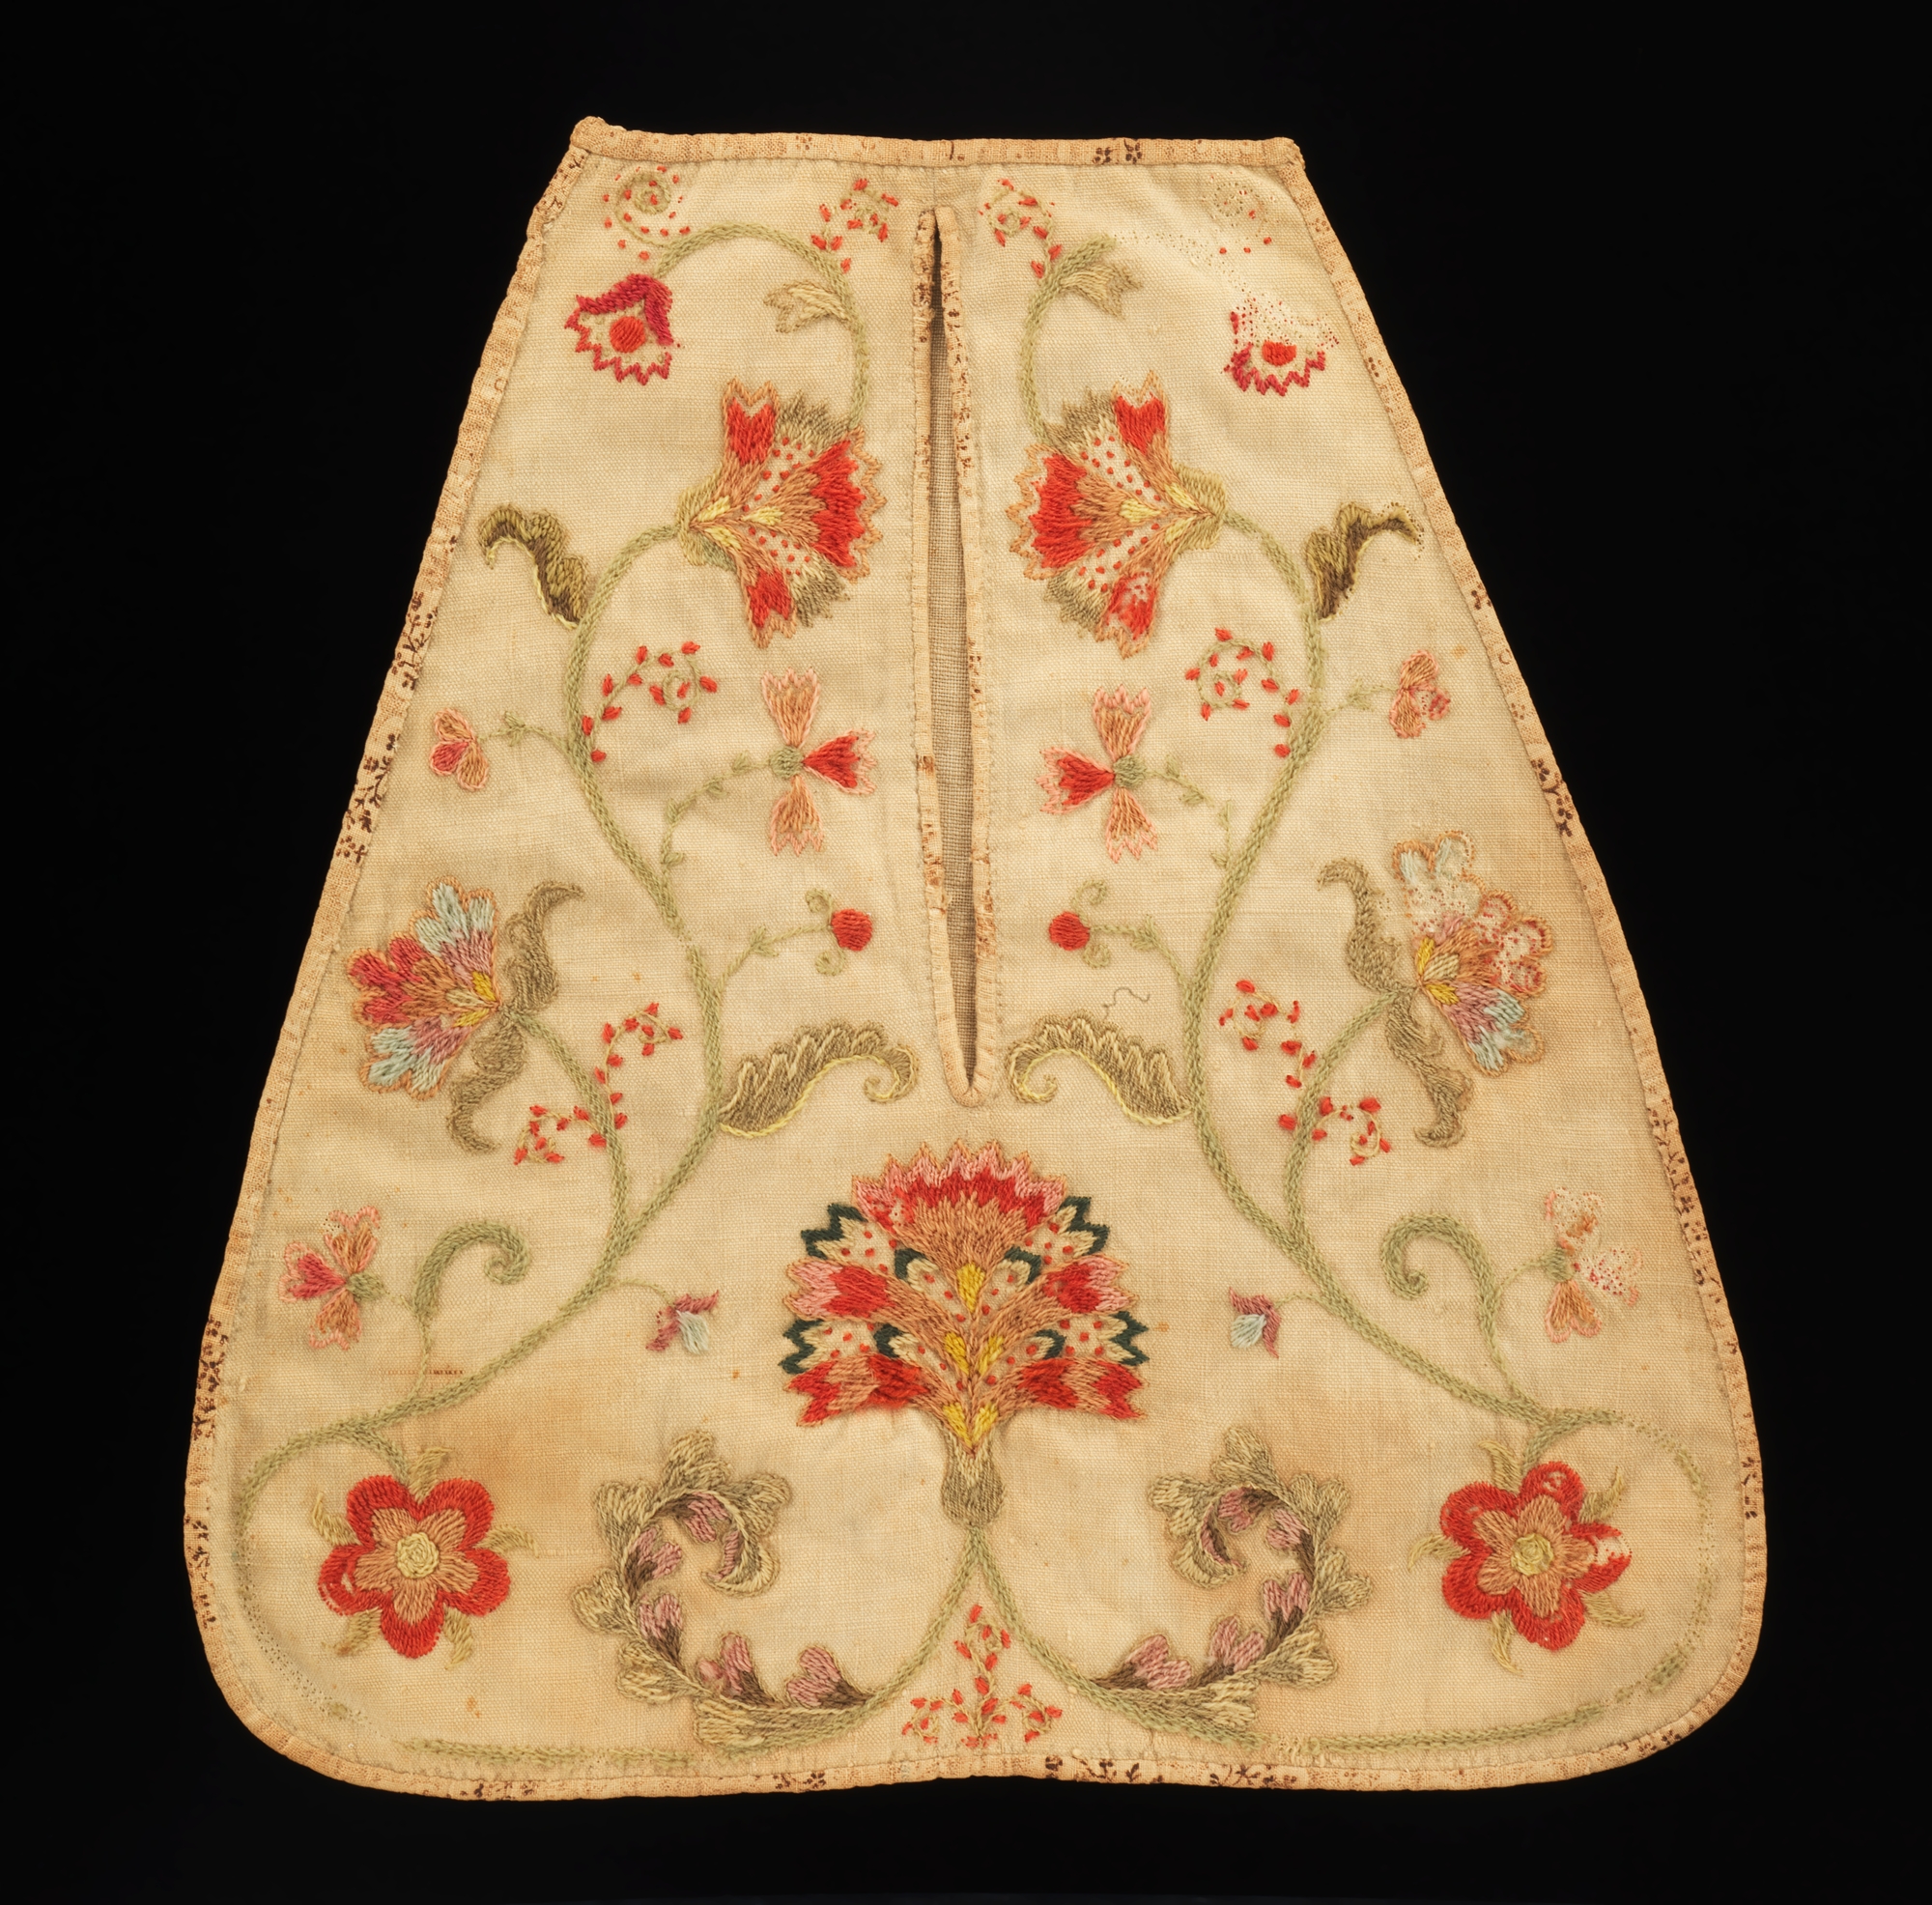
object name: pocket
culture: american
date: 1750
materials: linen, wool